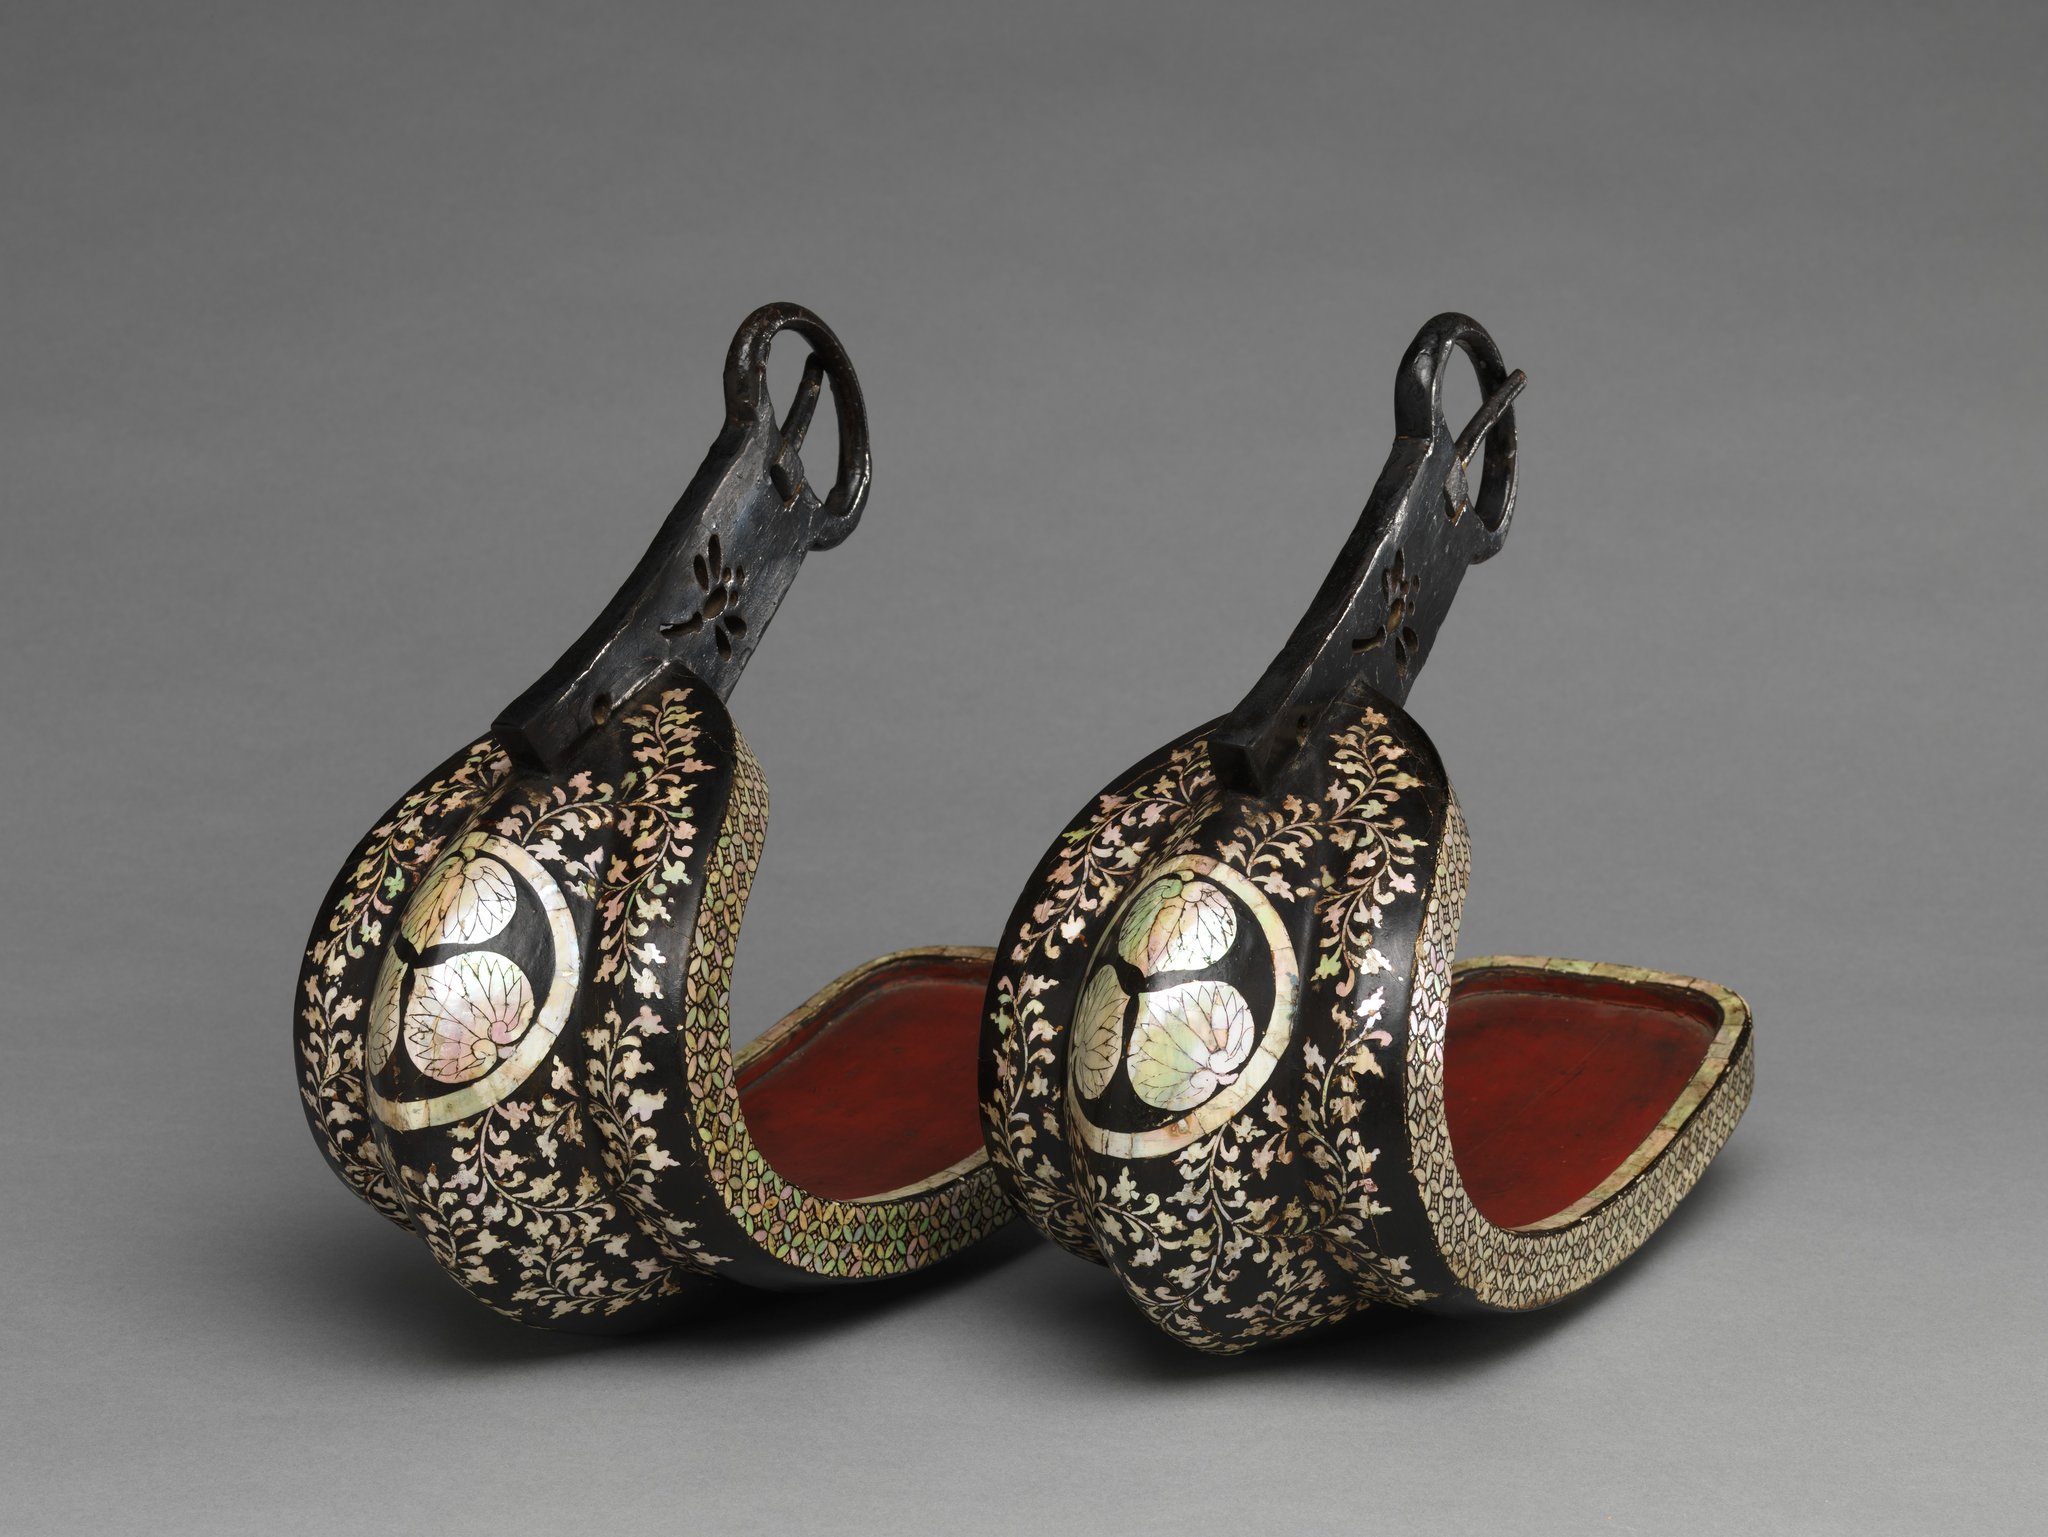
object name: pair of stirrup i abumi i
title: Pair of Stirrups (Abumi)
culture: japanese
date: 1567-1633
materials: iron, lacquer, mother of pearl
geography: japan